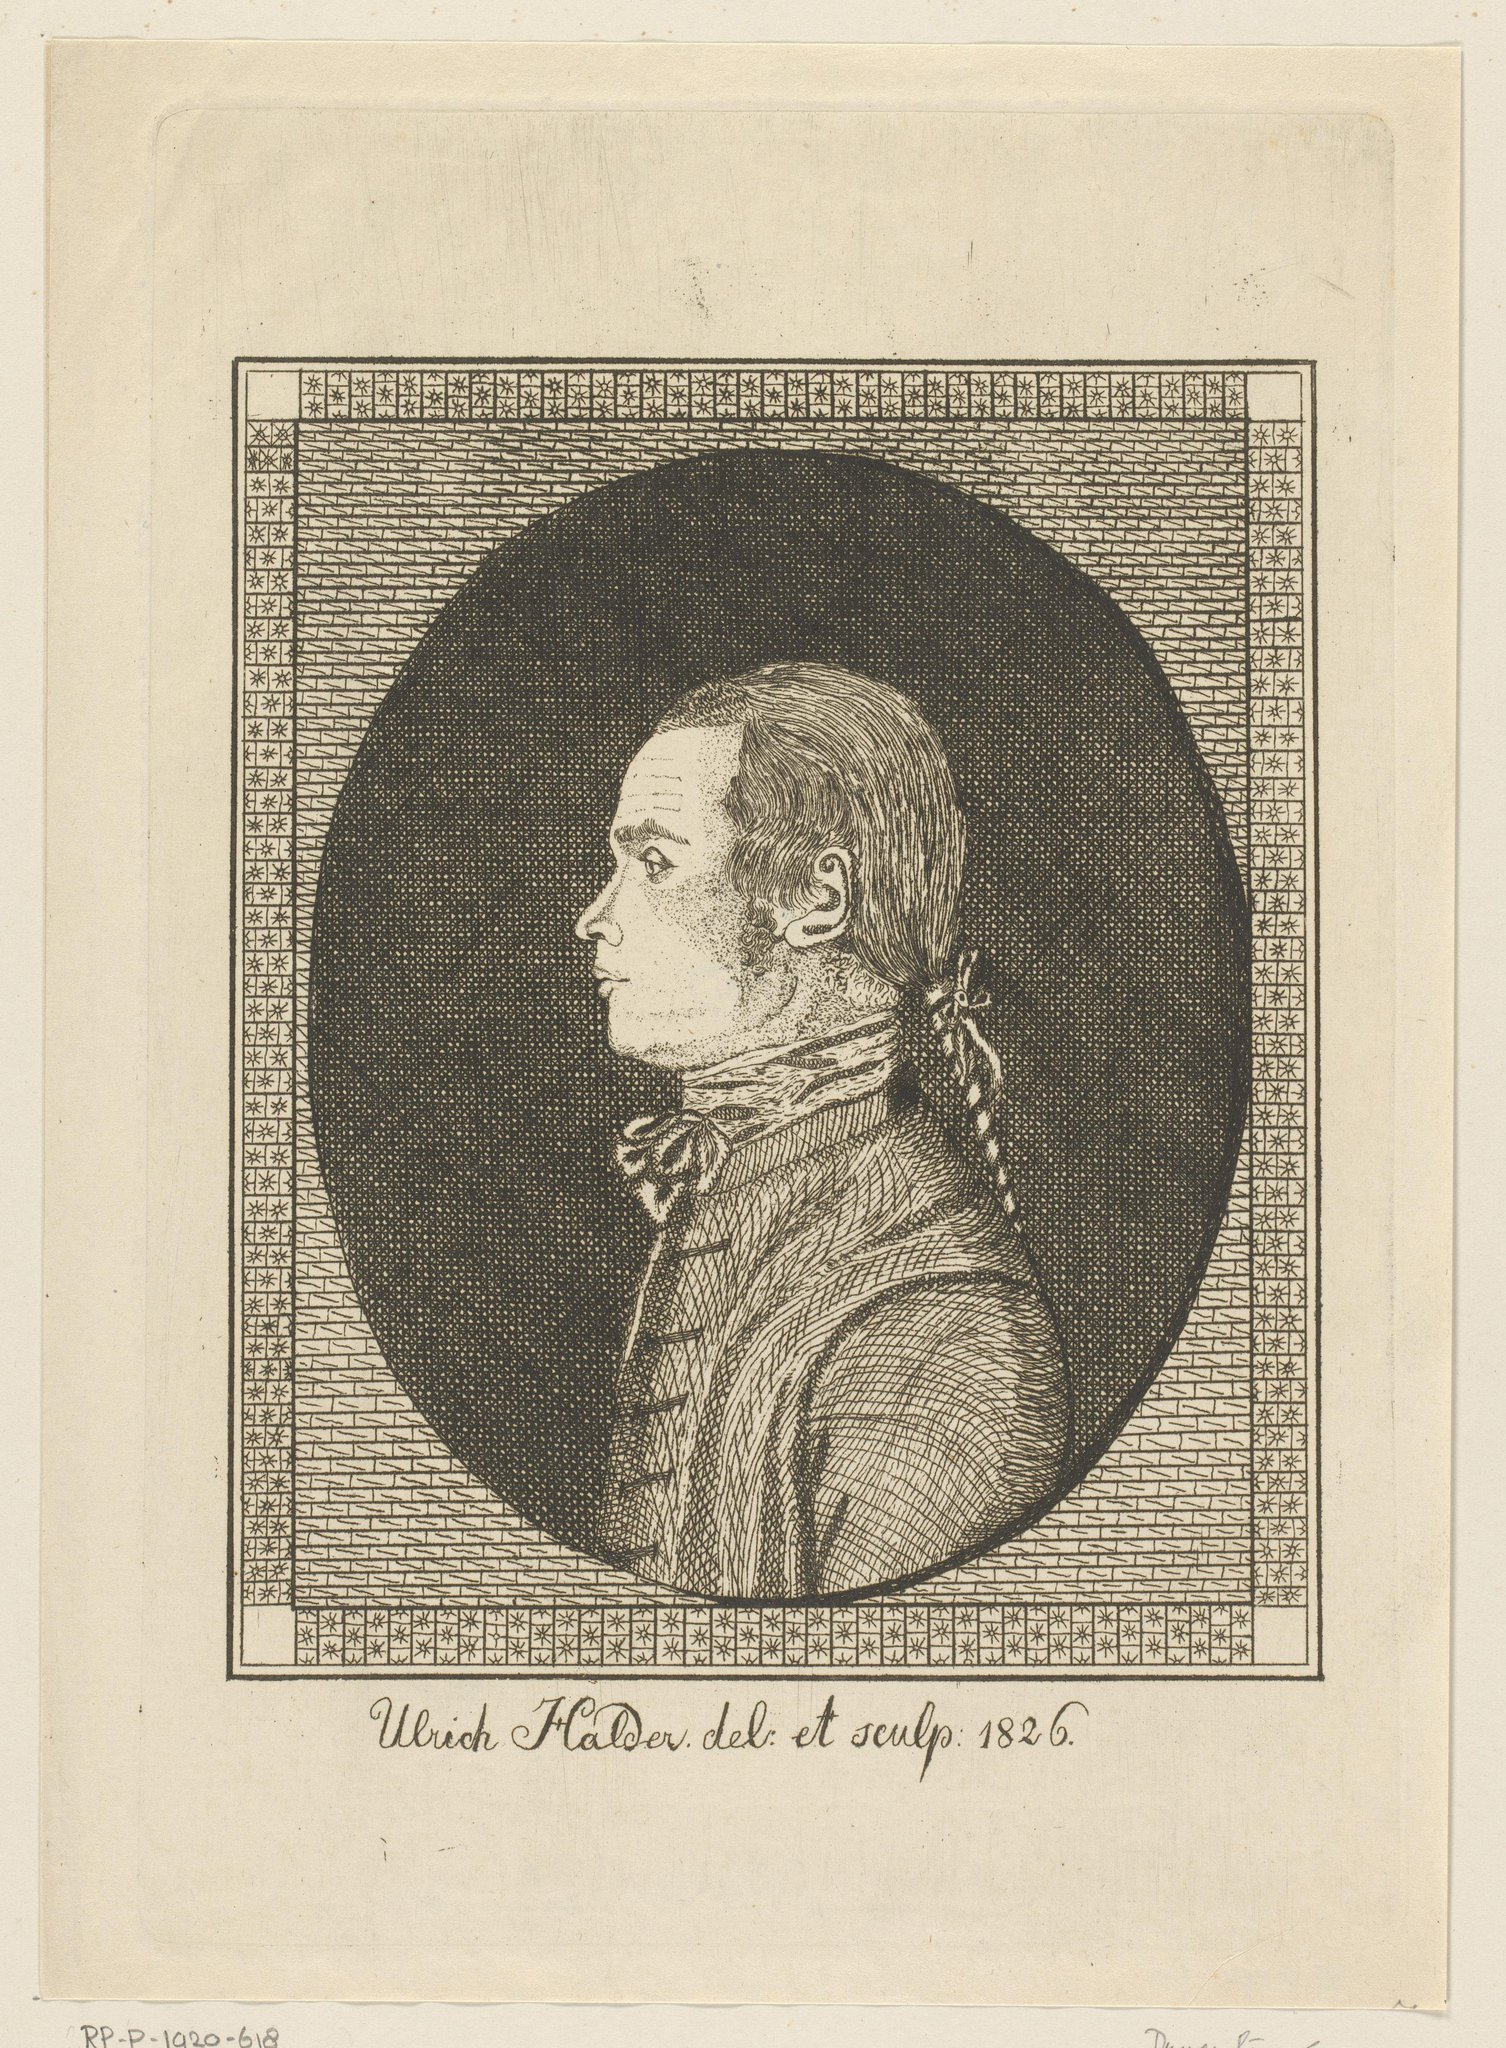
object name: print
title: Zelfportret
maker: ulrich halder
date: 1826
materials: paper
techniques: etching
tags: ulrich halder, historical persons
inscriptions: date